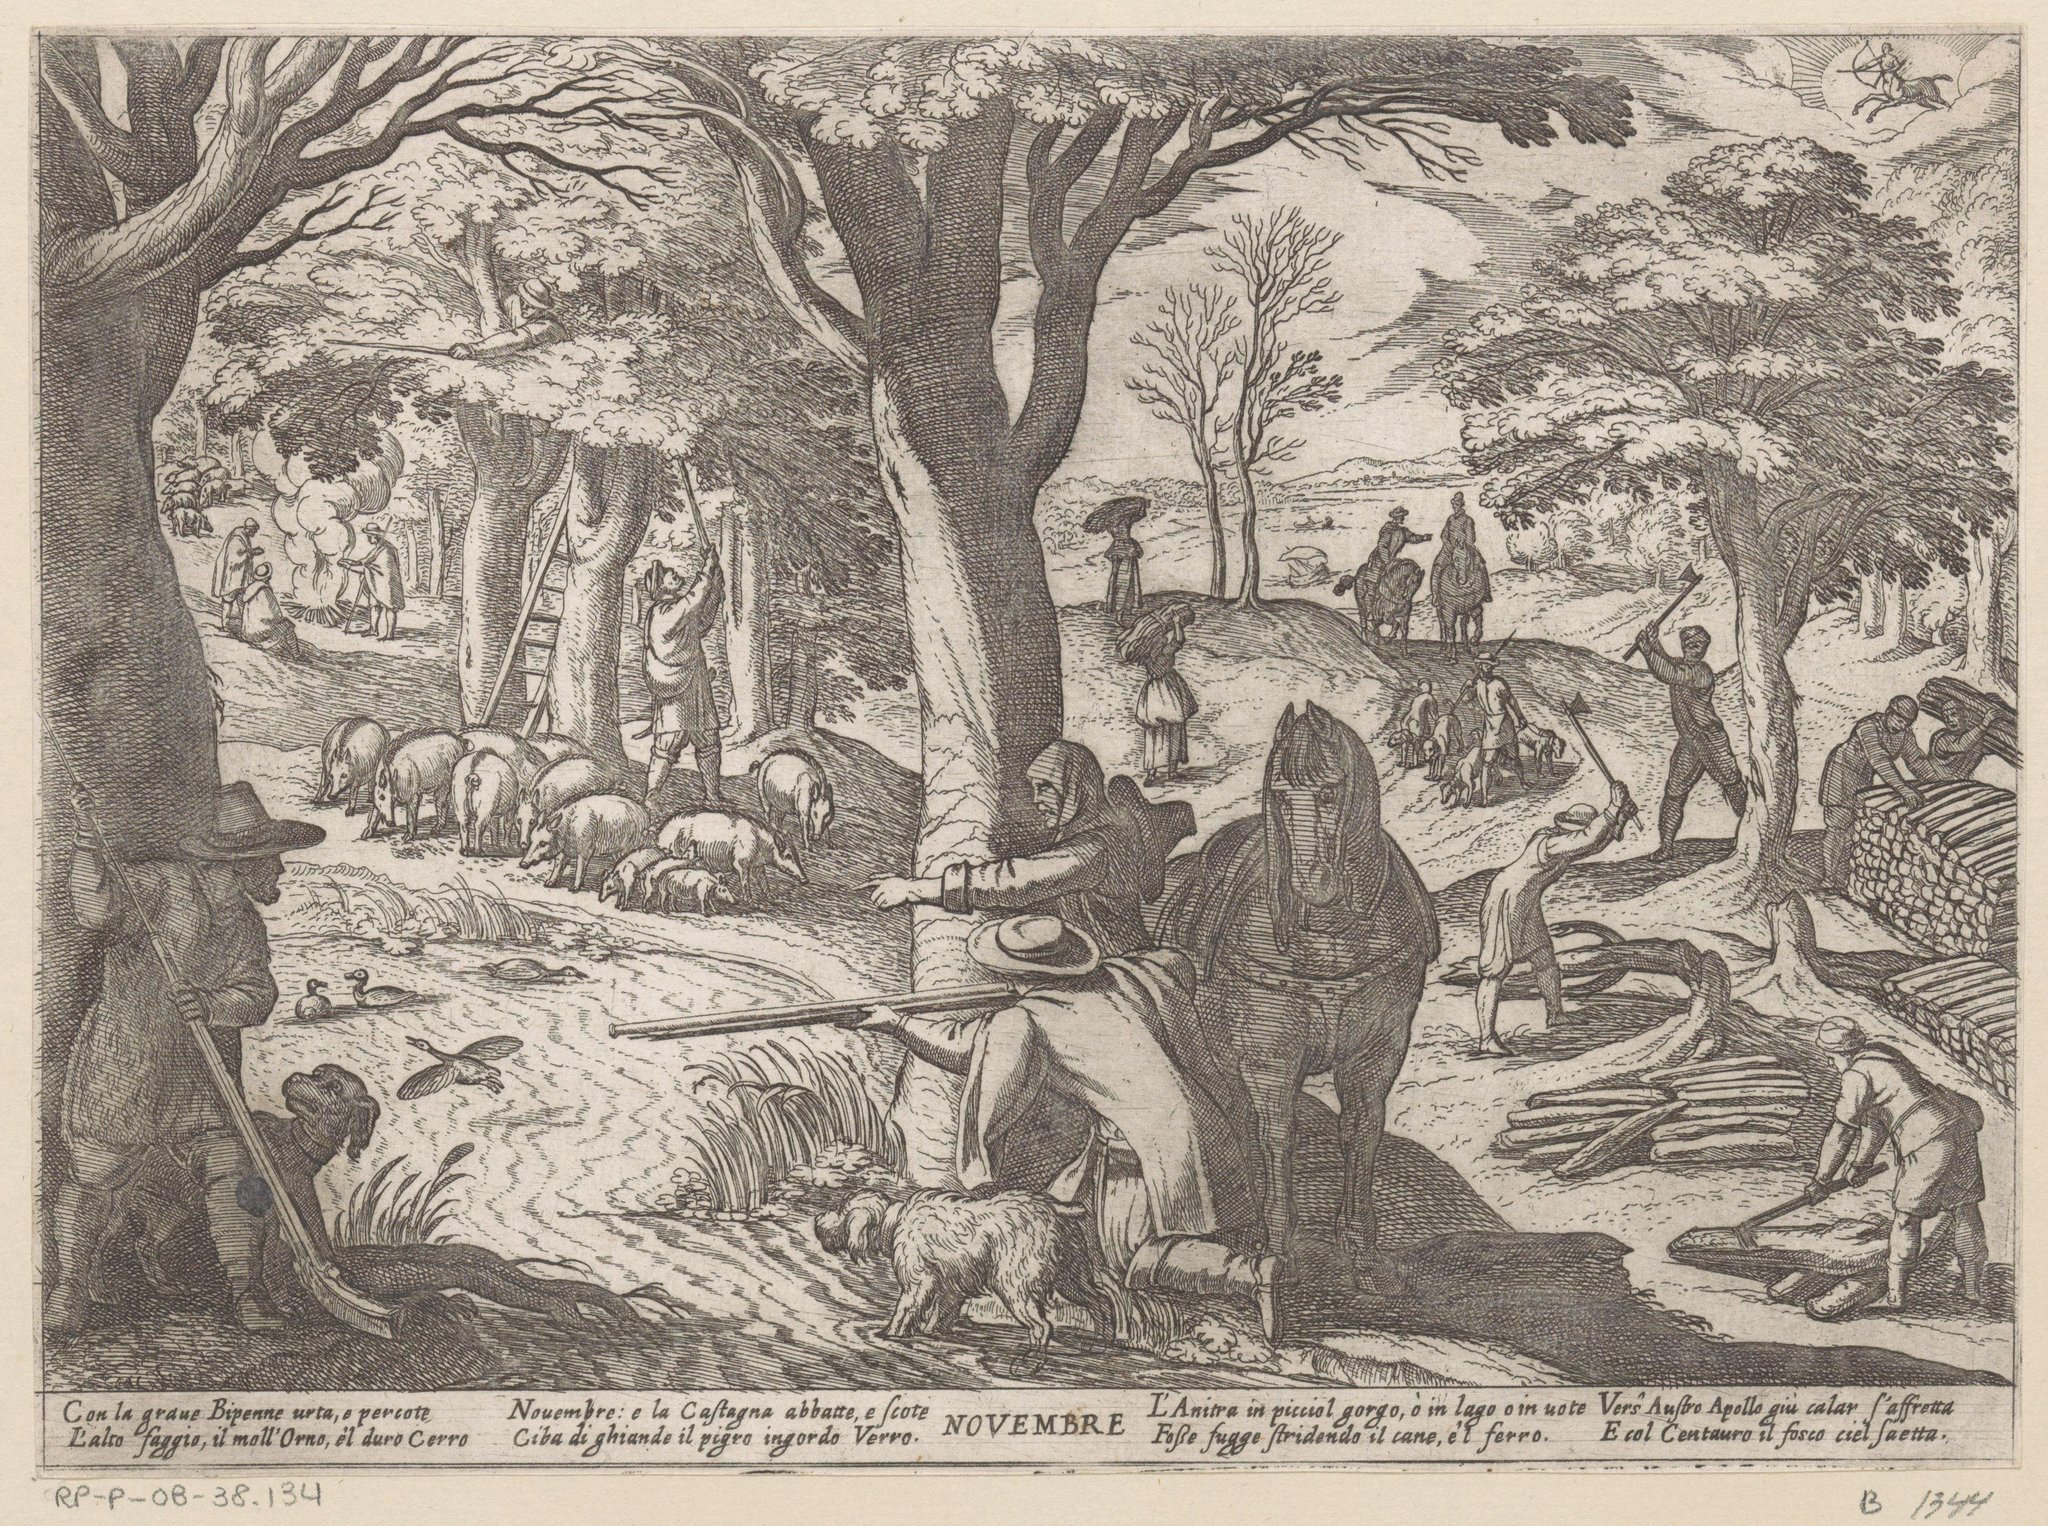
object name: print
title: Novembre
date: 1599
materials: paper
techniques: etching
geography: italy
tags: the twelve months represented by scenes showing human activities, usually in a landscape; so-called 'labours of the months', woodcutting, woodcutter ~ forestry, hunters hunting (n.b.: in 1988-1990 this notation denoted the concept of 43c11421 'hunters resting during the hunt'), sagittarius (zodiacal sign of november)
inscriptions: collector's mark: Lugt 240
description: Verbeelding van menselijke activiteit in de maand november. Boslandschap met jagers jagend op eenden en houthakkers die bomen kappen. Midden boven het symbool voor het sterrenbeeld boogschutter. Italiaans vers en titel in ondermarge.